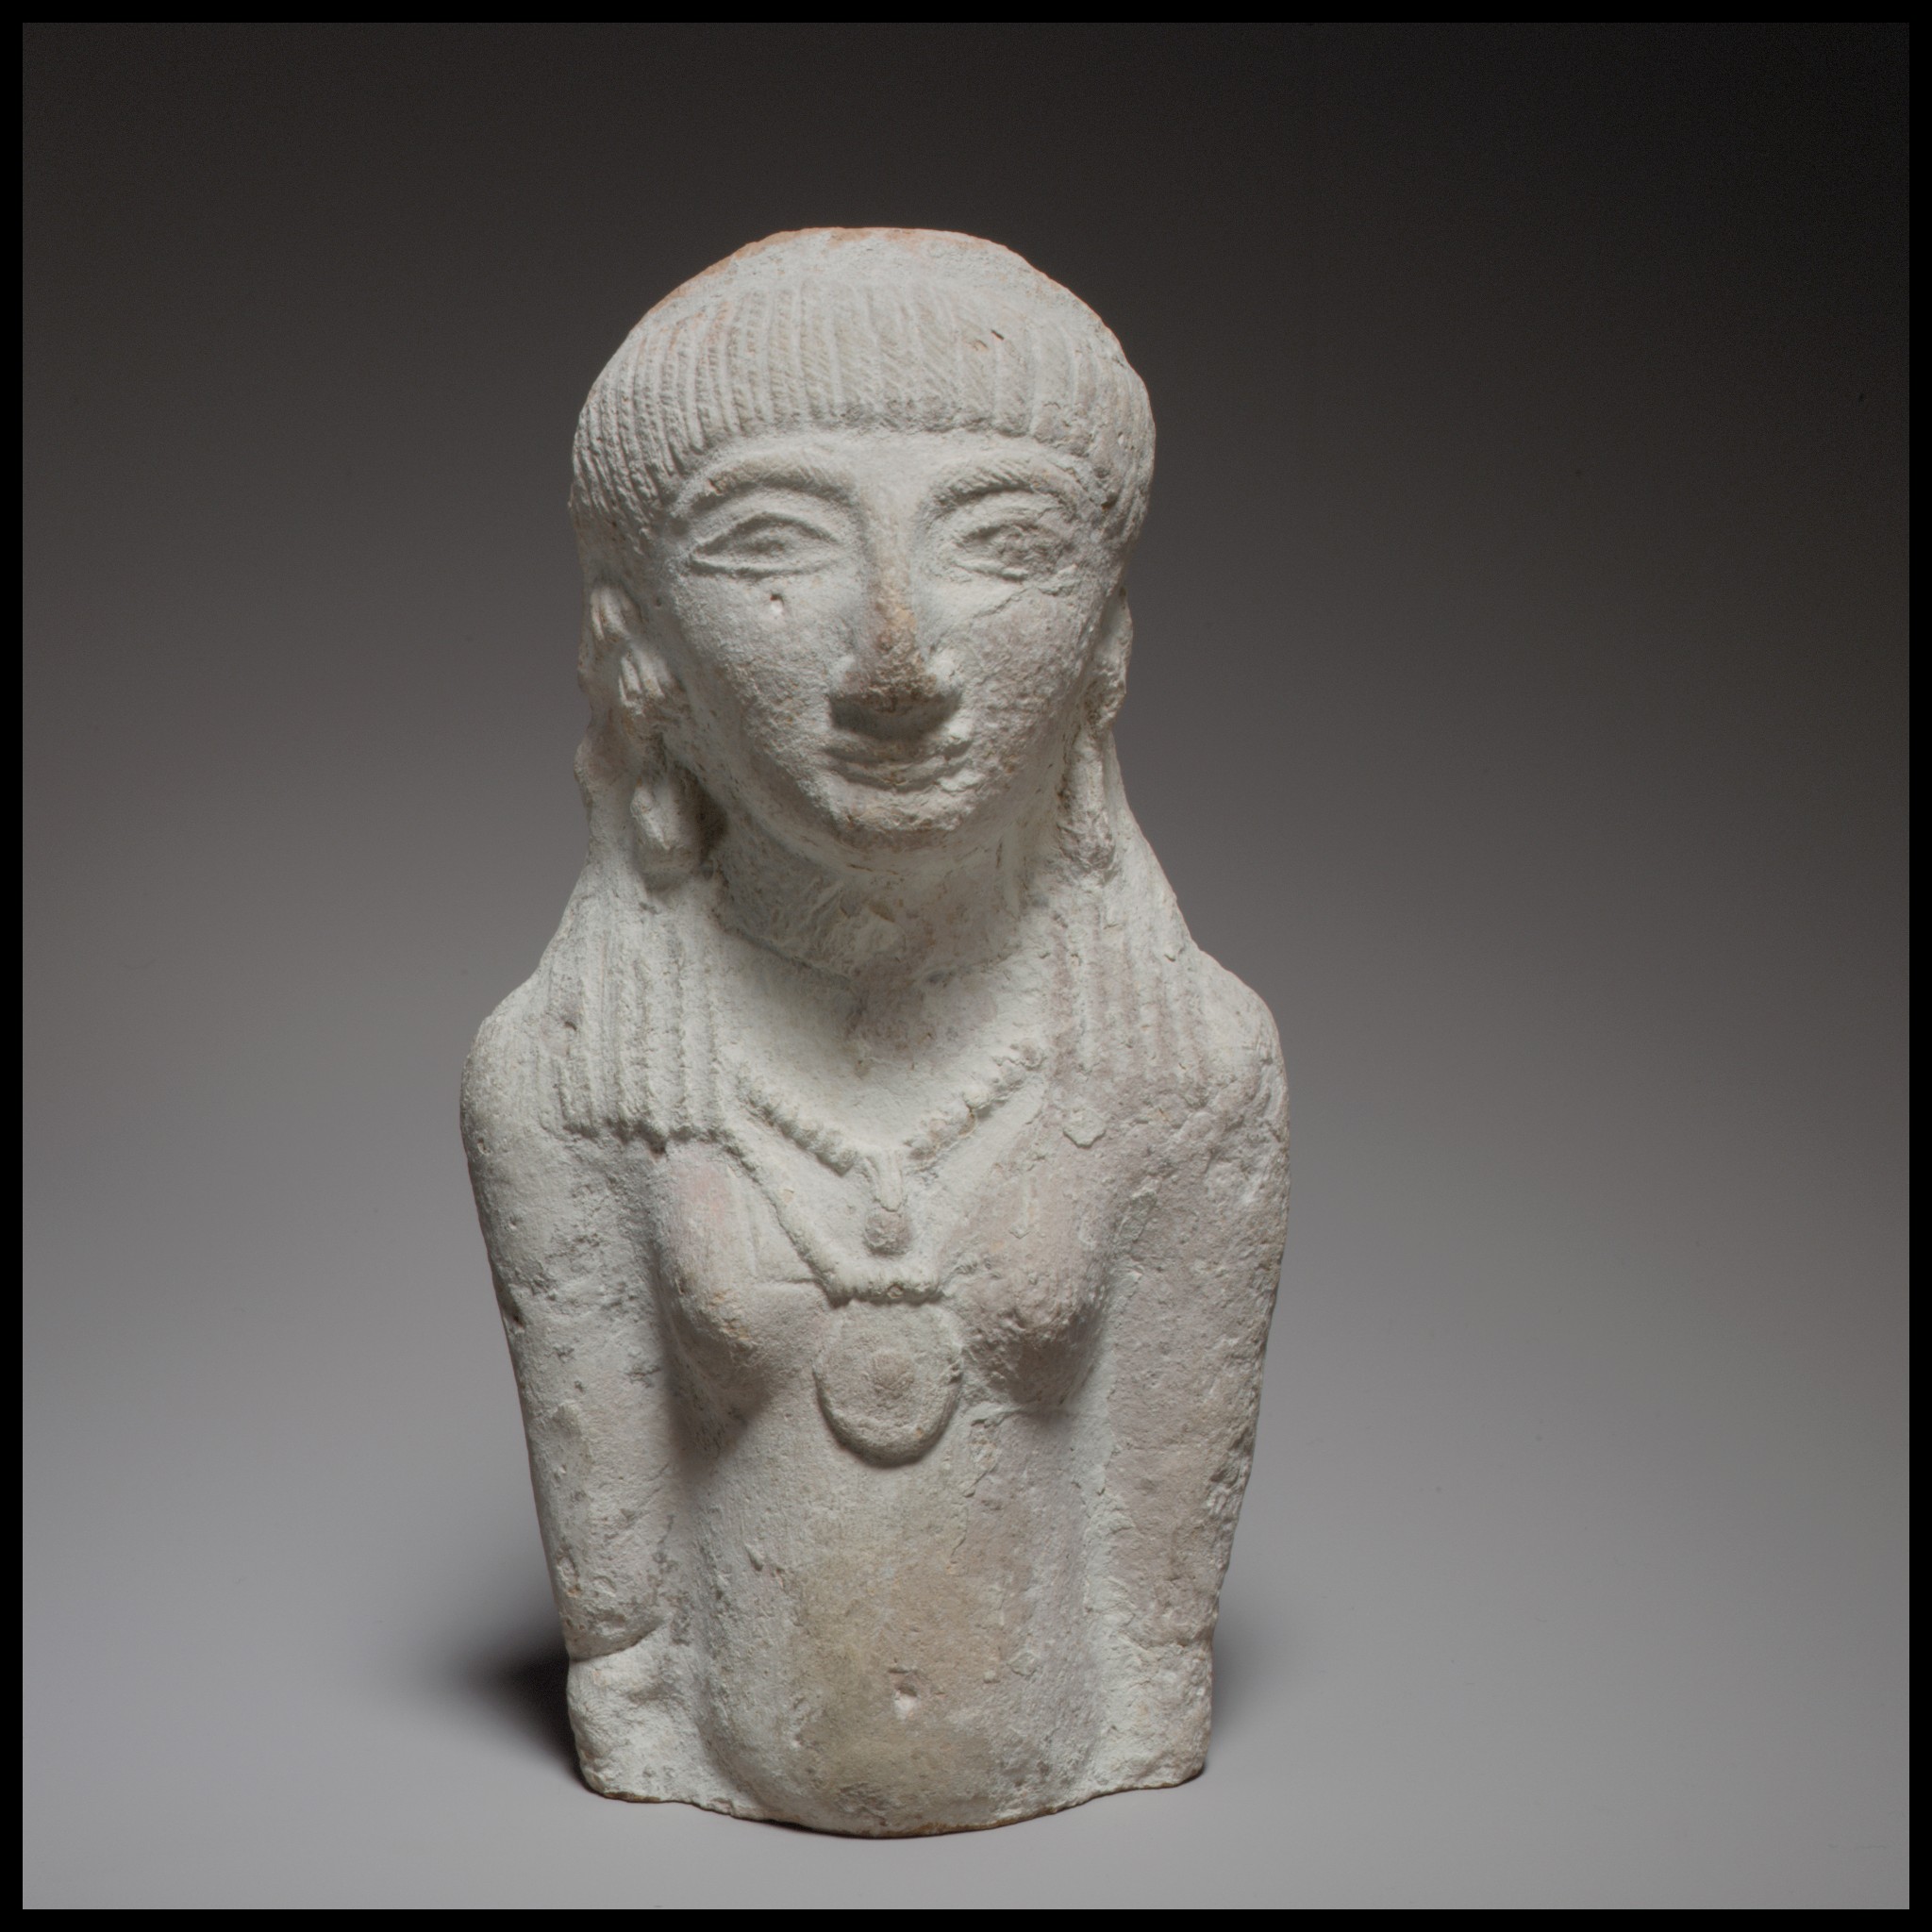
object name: statuette of a woman, upper part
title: Standing female figurine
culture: cypriot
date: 600-480 BCE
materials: terracotta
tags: women